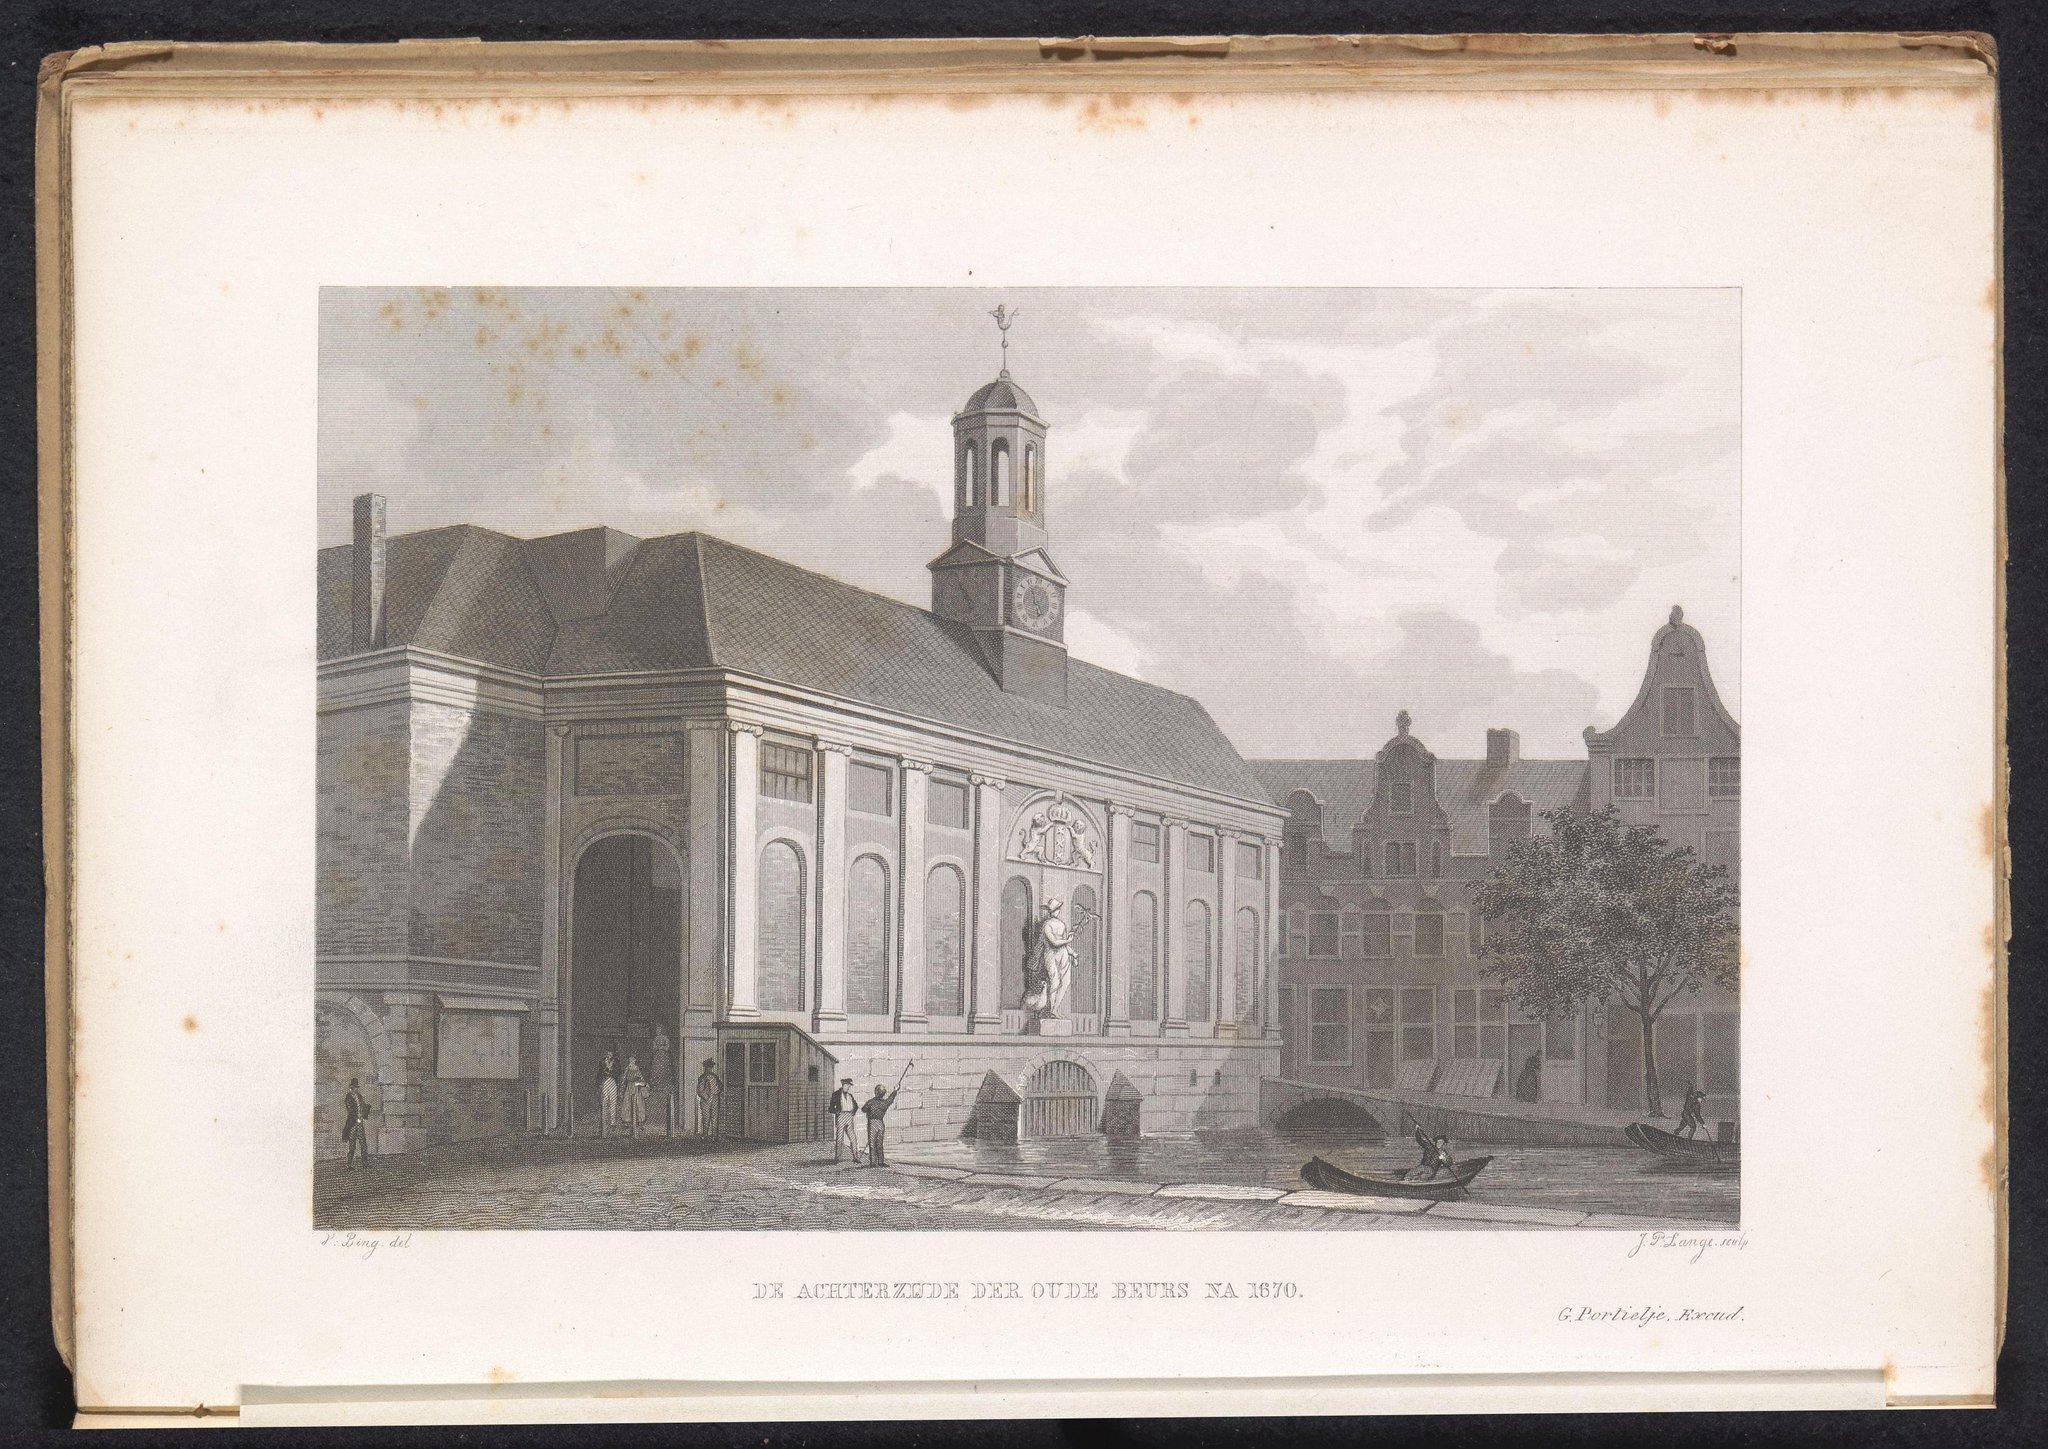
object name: book illustration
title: Gezicht op de achterzijde van de Beurs van Hendrik de Keyser te Amsterdam, na 1670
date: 1846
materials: paper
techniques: engraving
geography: amsterdam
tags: stock exchange, stock-market, rowing-boat, canoe, etc., canals, waters (in city) (+ city(-scape) with figures, staffage)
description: Gezicht op de achterzijde van de oude beurs van Hendrik de Keyser te Amsterdam zoals het eruit zag na 1670. Illustratie in een boek uit 1846 over de oude en nieuwe beurs van Amsterdam.